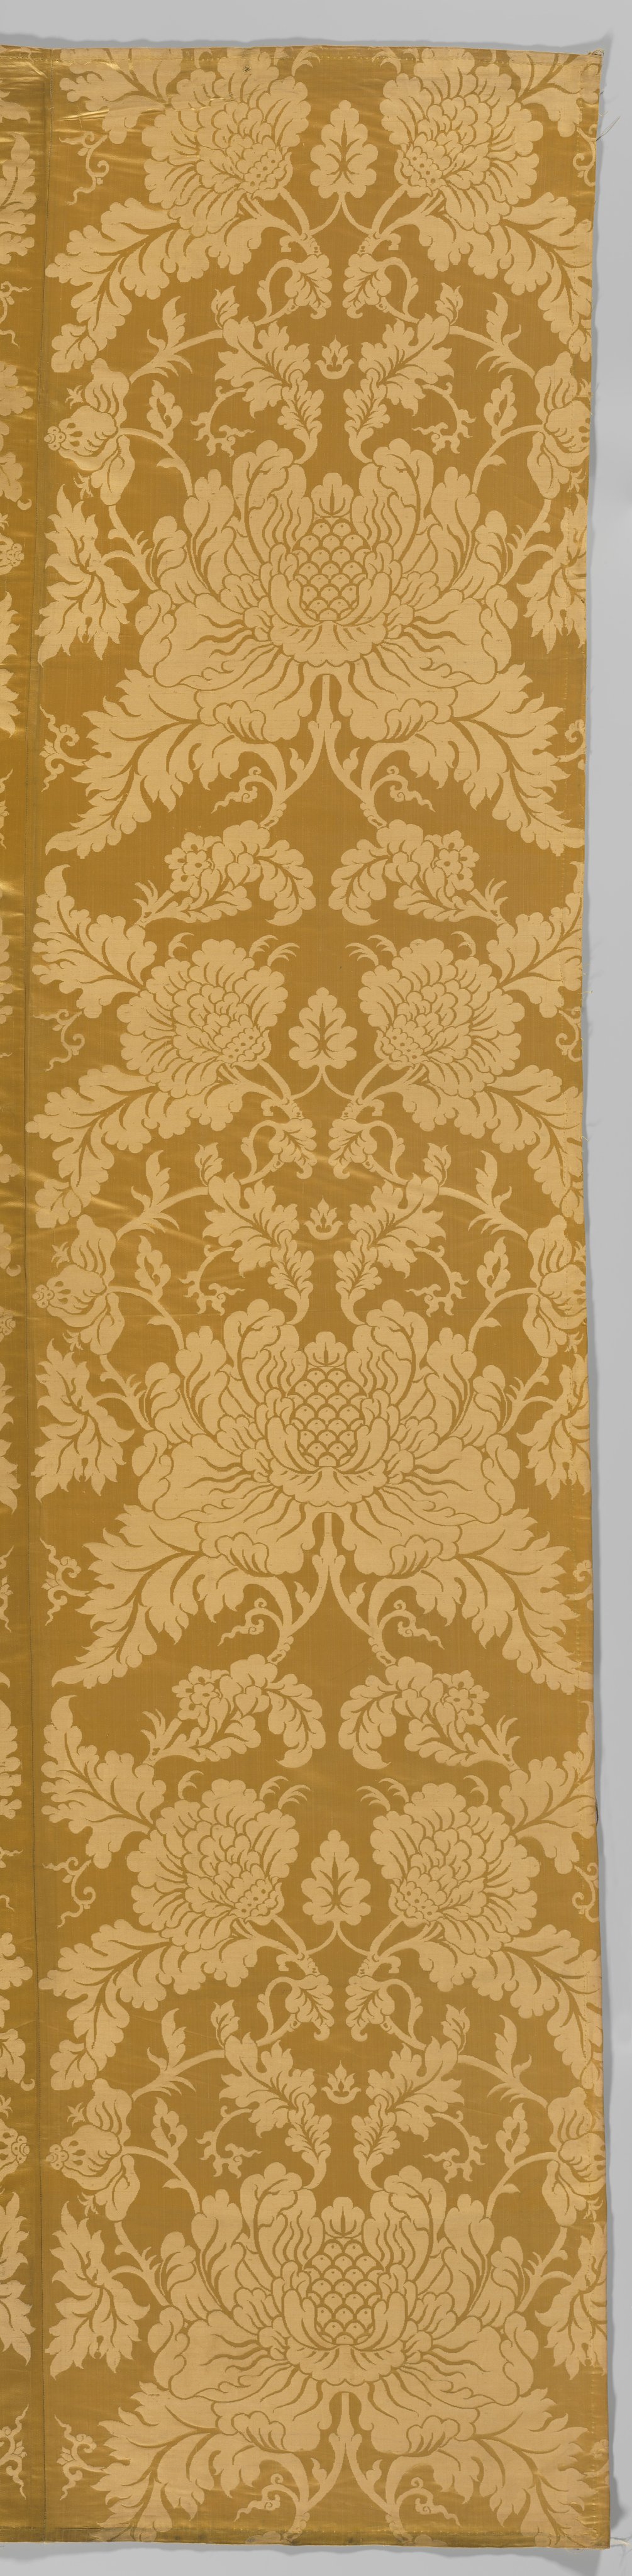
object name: upholstered wall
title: Wandbespanning van geel zijden damasten met symmetrisch patroon van twee opgaande golvende ranken met onder andere pioenvormige bloemen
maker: Anonymous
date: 1700-1725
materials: silk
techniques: damask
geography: france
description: Geel zijden damasten wandbespanning. Symmetrisch patroon van twee opgaande golvende ranken waaraan grote pioenvormige bloemen met geschubtd hart; kleinere bloemen zijn paarsgewijs geplaatst, evenals bloemknoppen, gevederde bladeren en arabeskrankjes, die eindigen in wolkenbanden. Patroon van keperstreep, fond van satijnbinding. Afkomstig uit het pand Voorstraat 140 te Dordrecht. Eén baan heeft aan de onderkant wat waterschade. Eén deel heeft 2 aan elkaar genaaide banen, de andere 12. Zie ook V-66529-1 t/m 5, dit betreft vijf panelen waarbij op elk paneel één baan gemonteerd is.